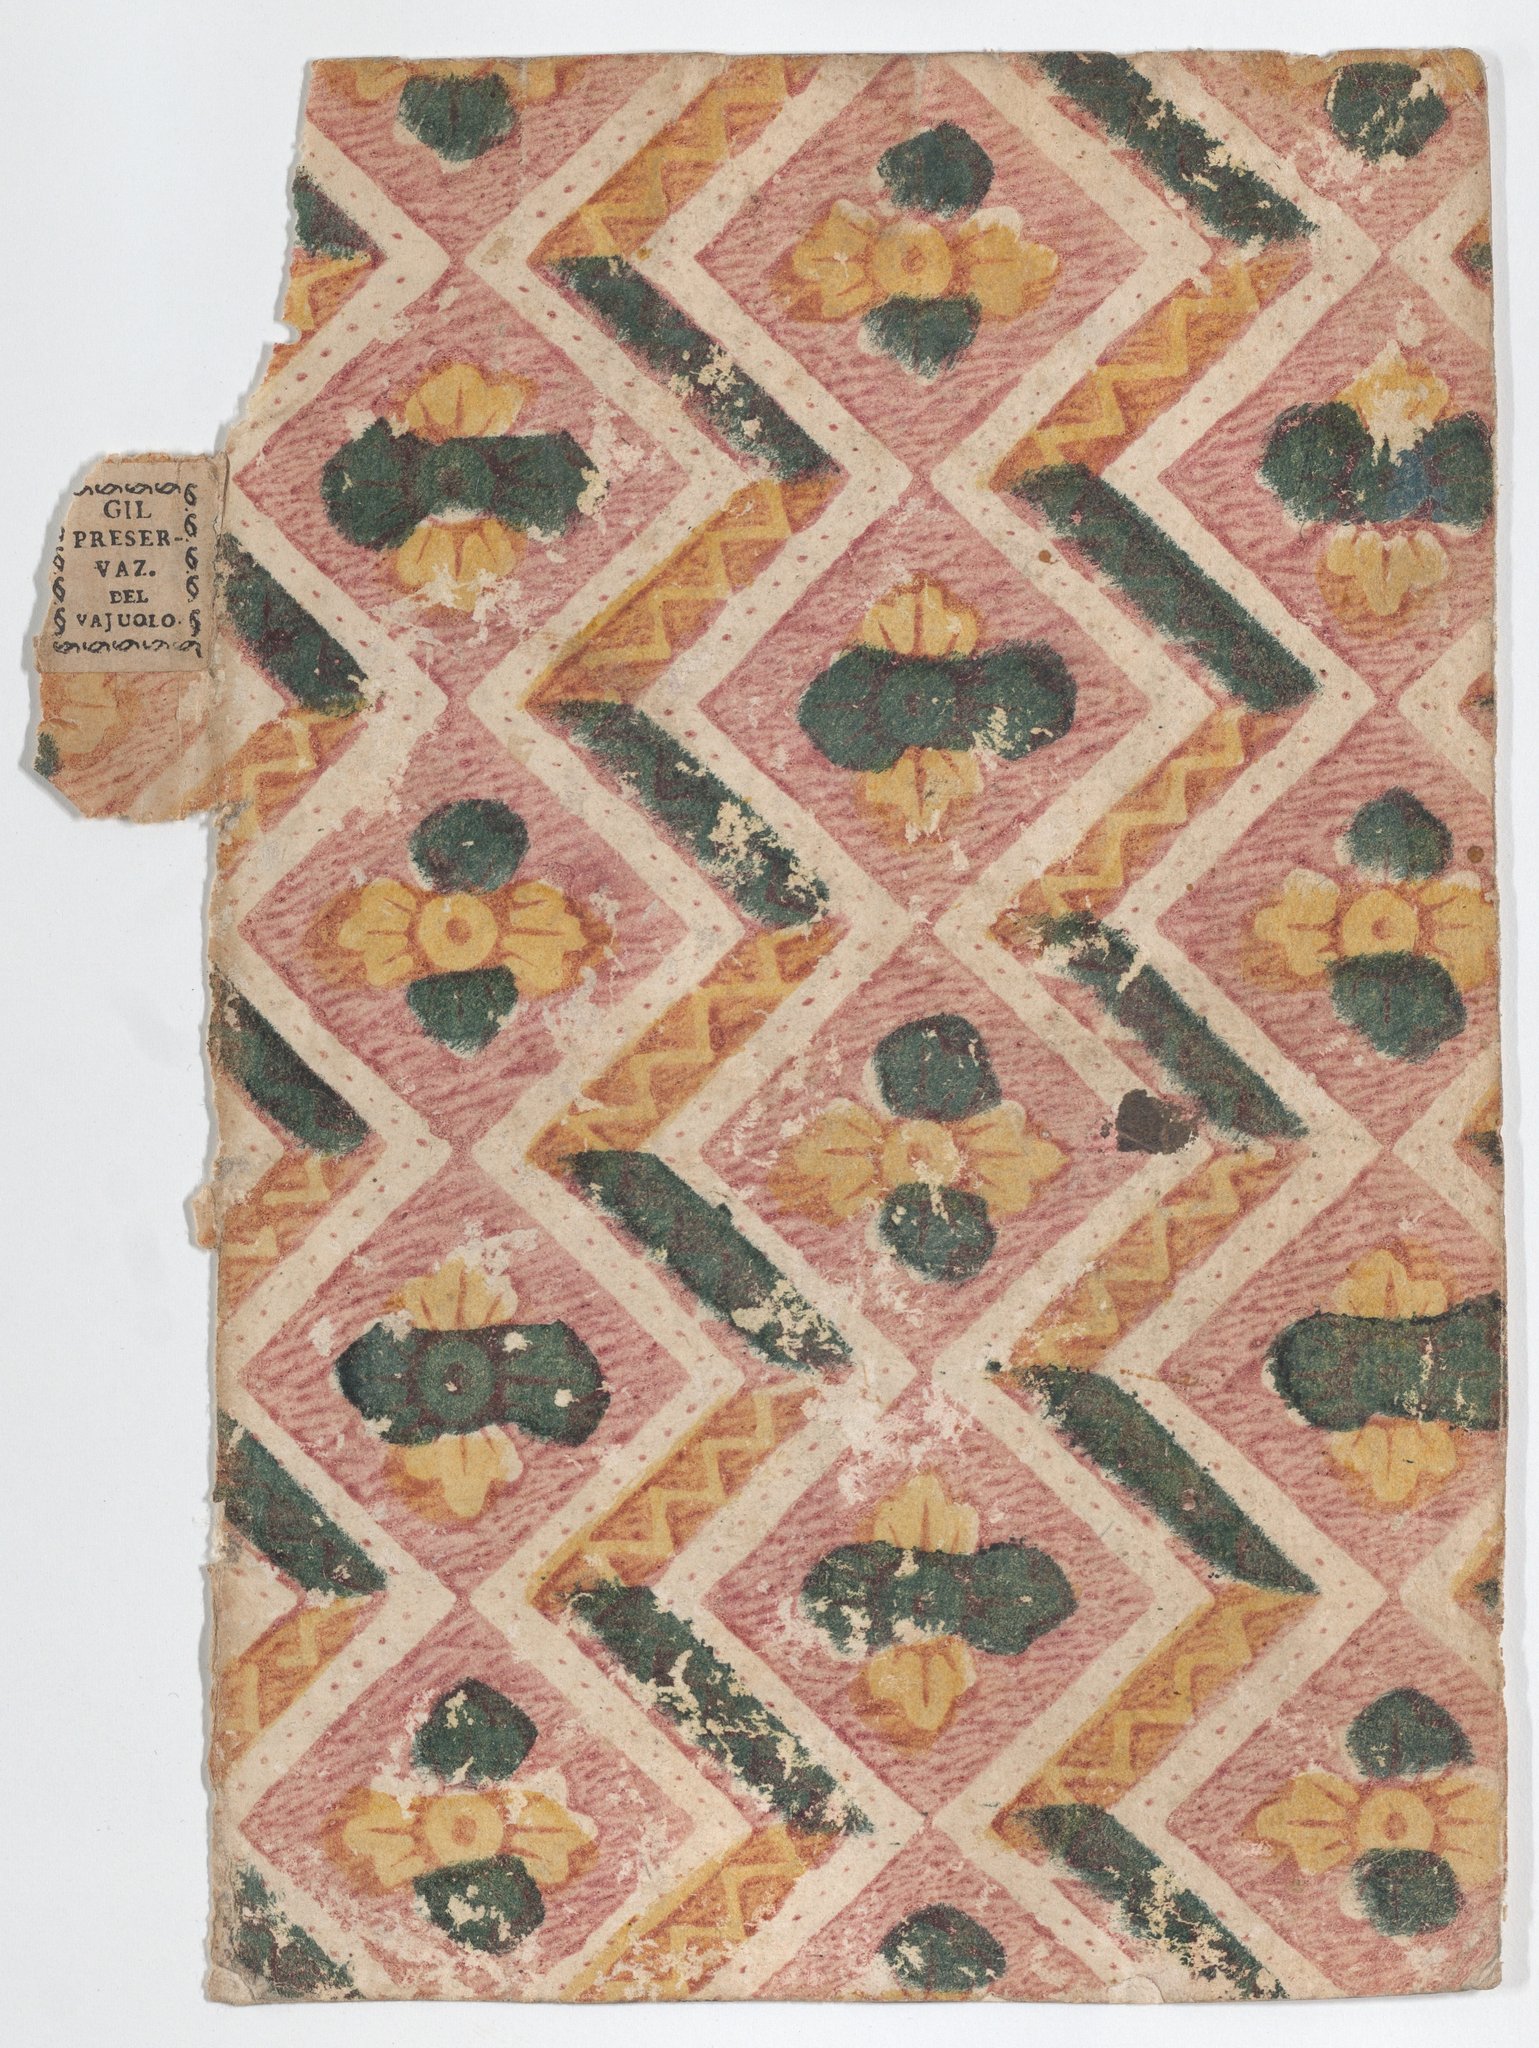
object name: print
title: Book cover with zigzag and floral pattern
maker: Anonymous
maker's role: artist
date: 1701-1800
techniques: relief print